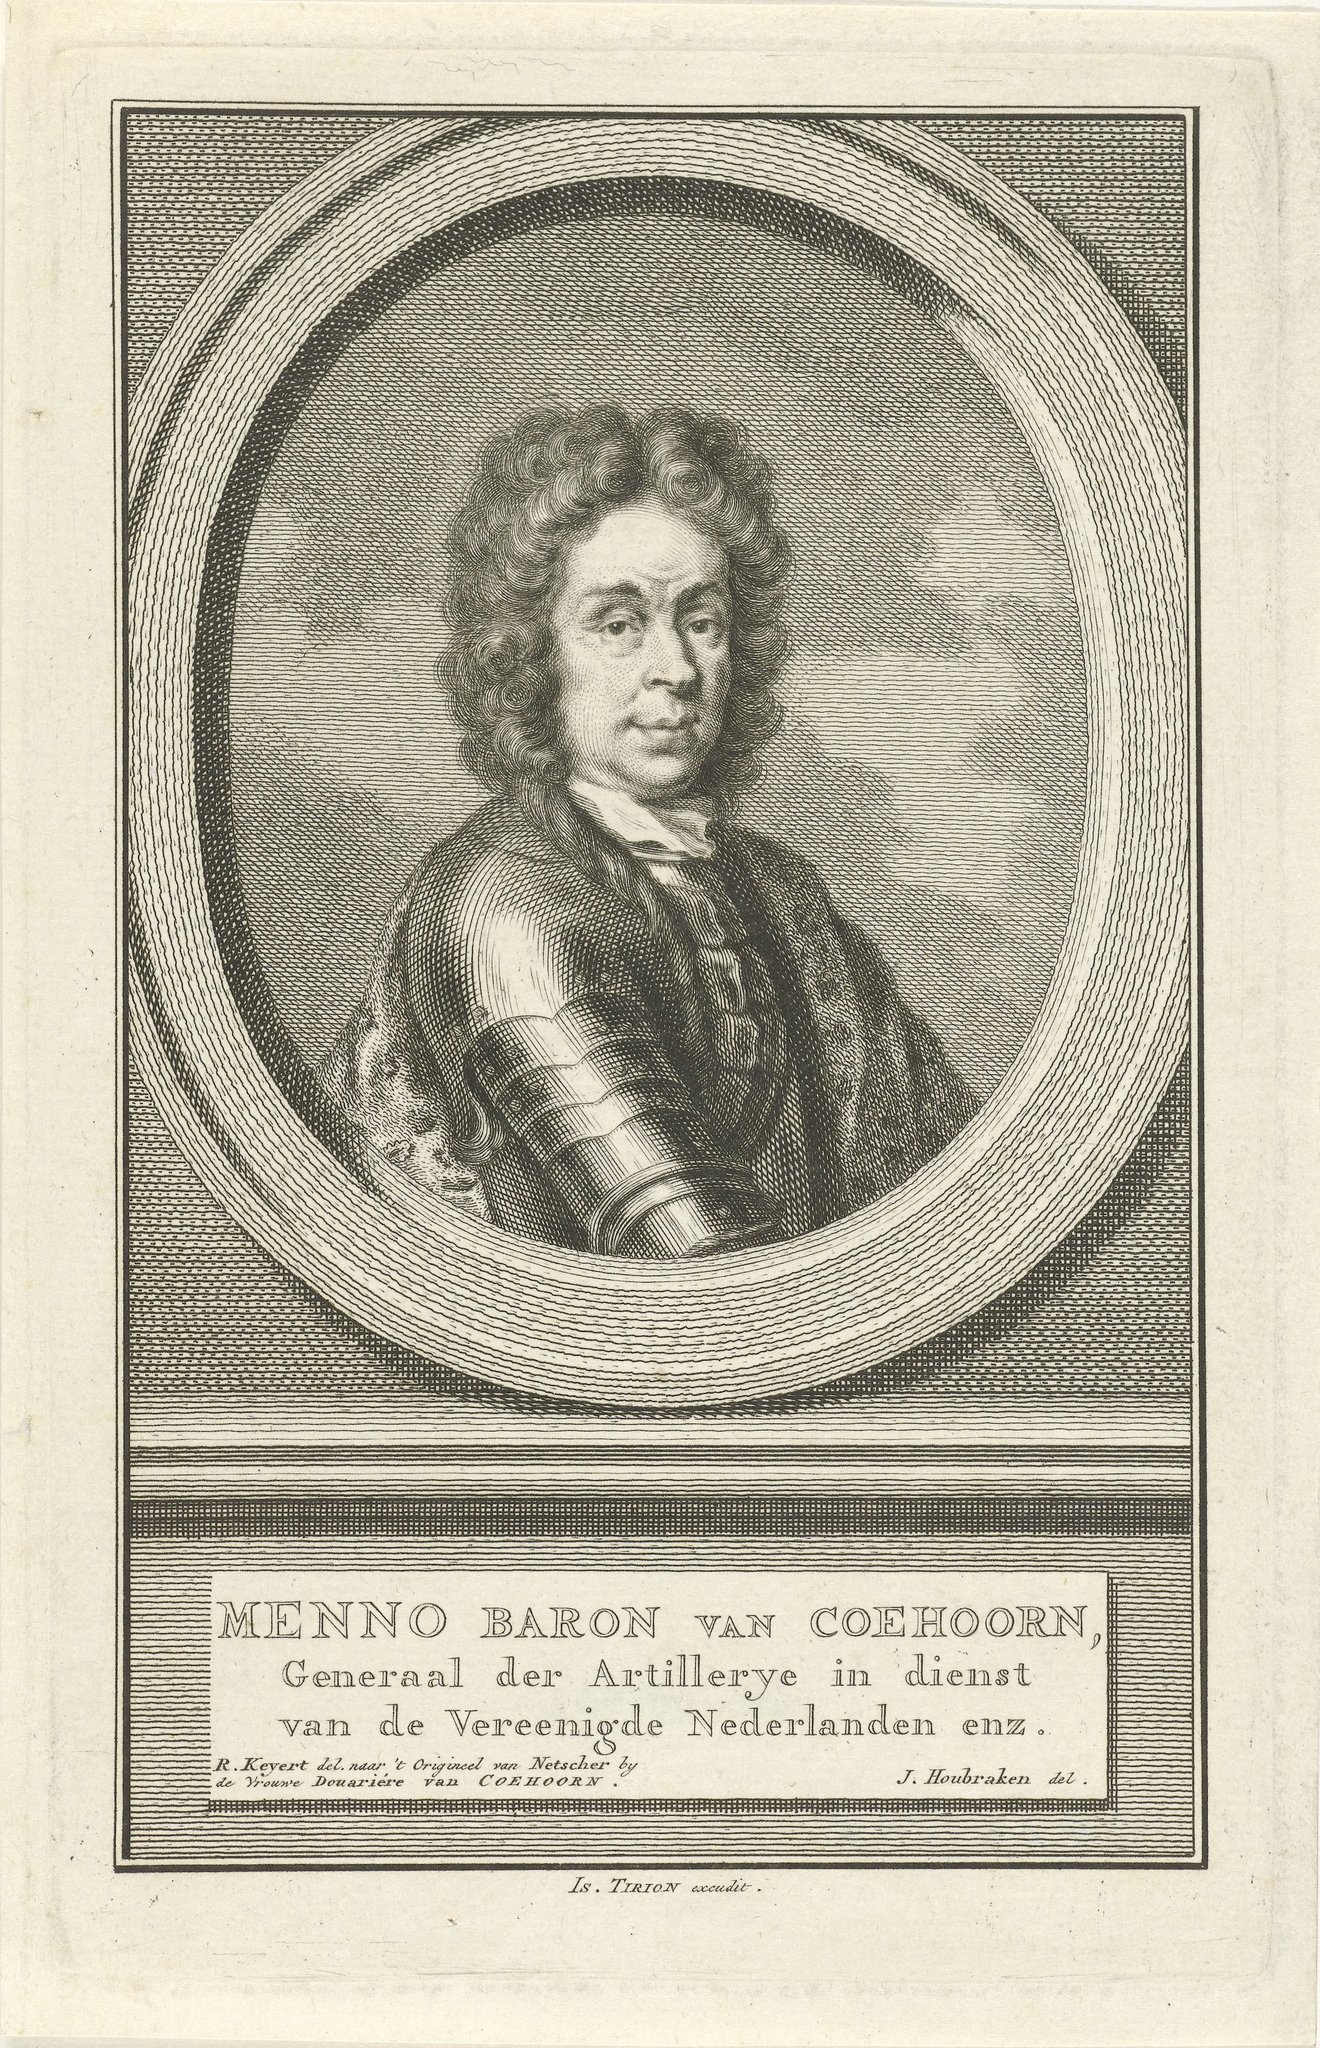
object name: print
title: Portret van Menno baron van Coehoorn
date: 1749-1759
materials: paper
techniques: engraving, etching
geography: amsterdam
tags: the hague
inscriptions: collector's mark: Lugt 2228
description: Prent ook gebruikt in: Jan Wagenaar, Vaderlandsche historie, vervattende de geschiedenissen der nu Vereenigde Nederlanden, inzonderheid die van Holland (...), 21 delen. Amsterdam, Isaak Tirion, 1749-59.